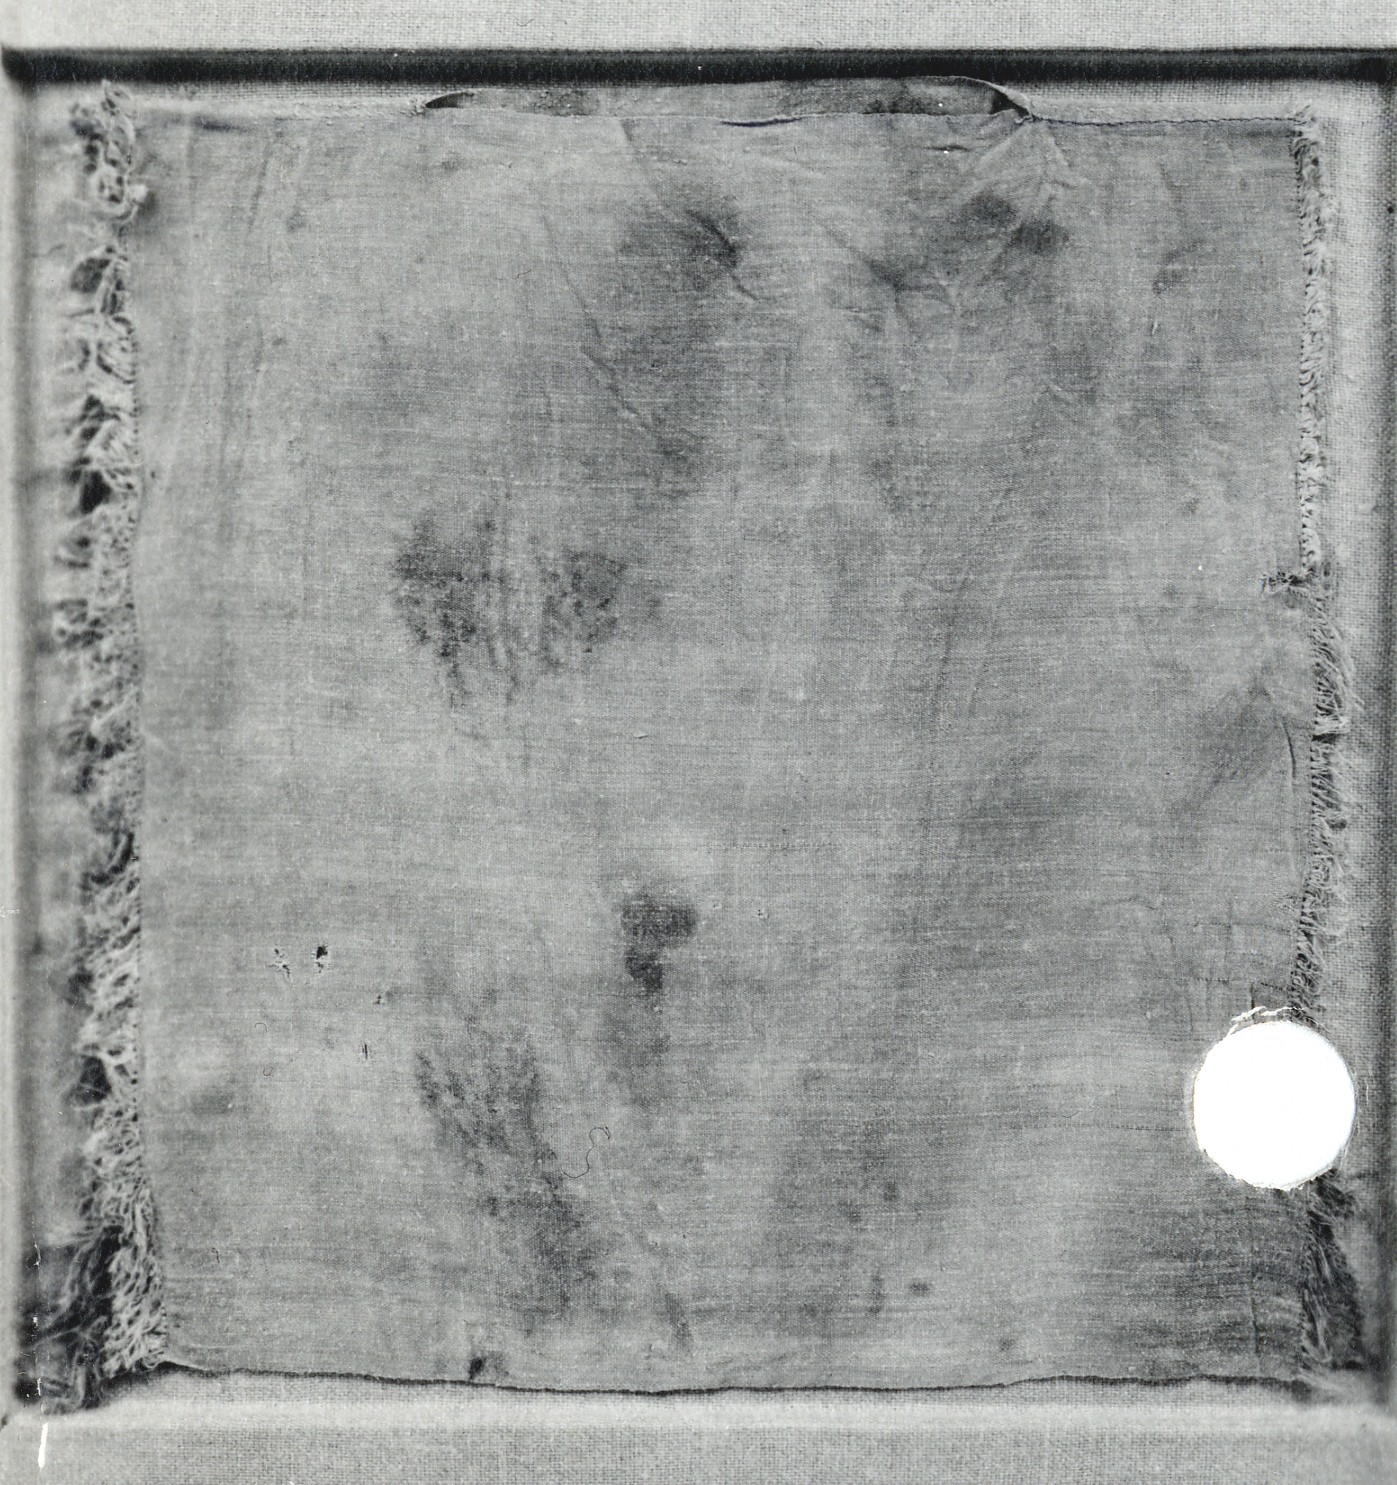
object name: dress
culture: coptic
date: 301-400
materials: linen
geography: egypt